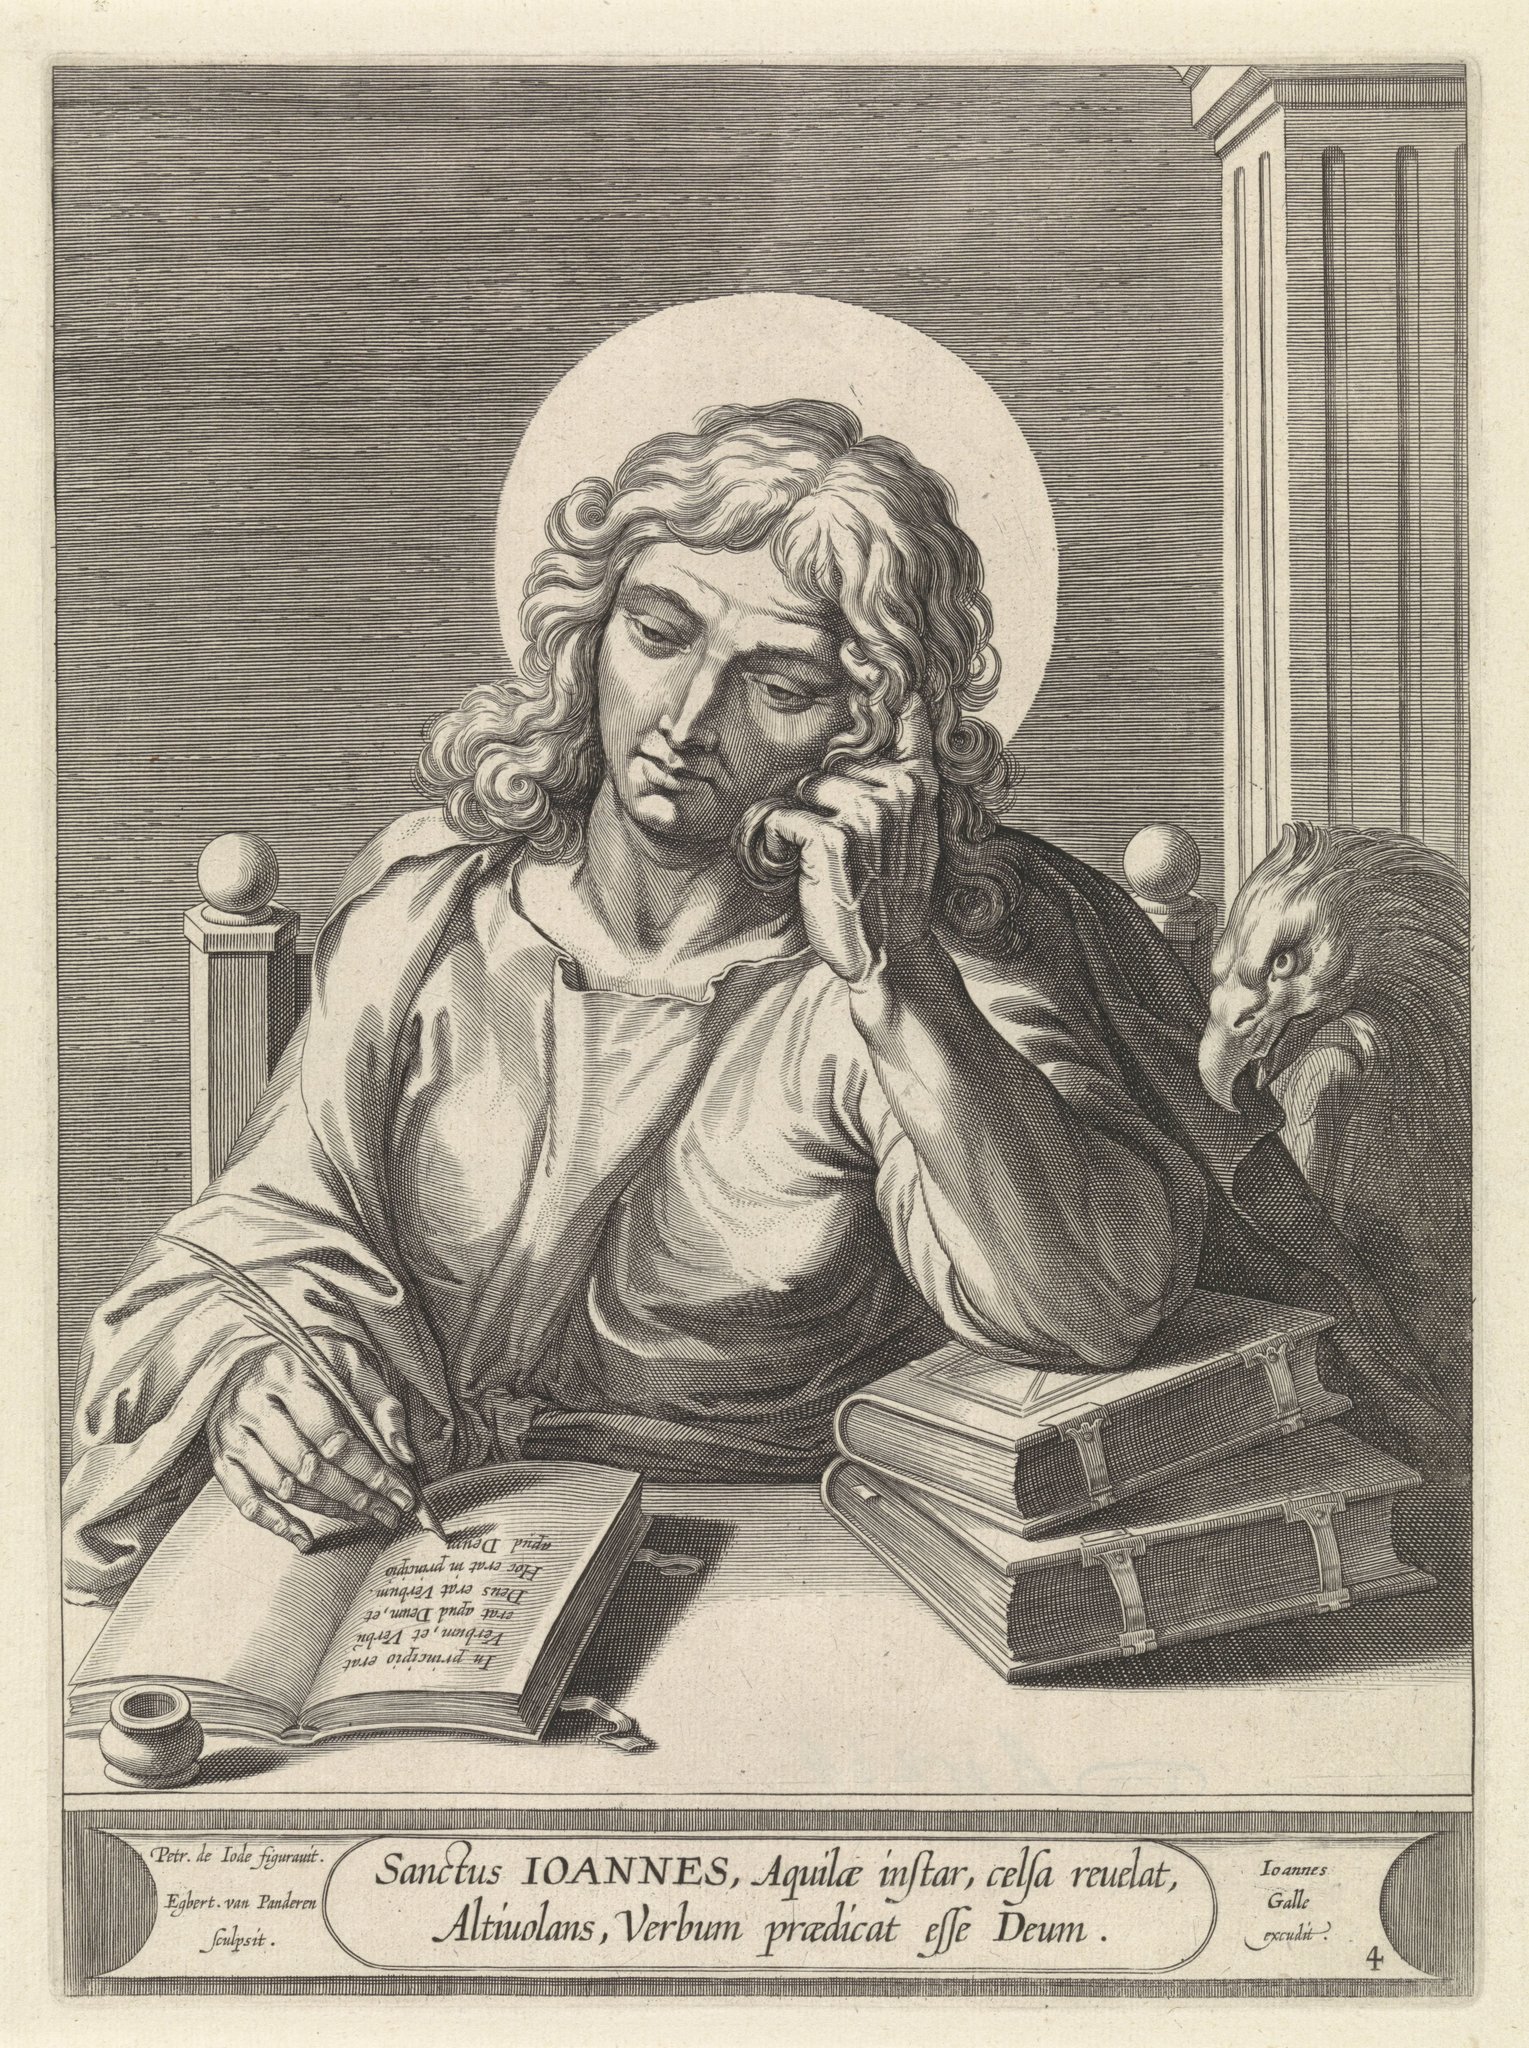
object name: print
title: Evangelist Johannes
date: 1590-1637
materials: paper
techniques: engraving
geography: antwerp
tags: st. john the evangelist writing the gospel, usually the eagle present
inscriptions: collector's mark: Lugt 2228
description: De evangelist Johannes, schrijvend aan een tafel met boeken. Naast hem zijn attribuut de adelaar. In een kader een tweeregelig onderschrift in het Latijn. Vierde prent uit een serie van vier met de evangelisten.